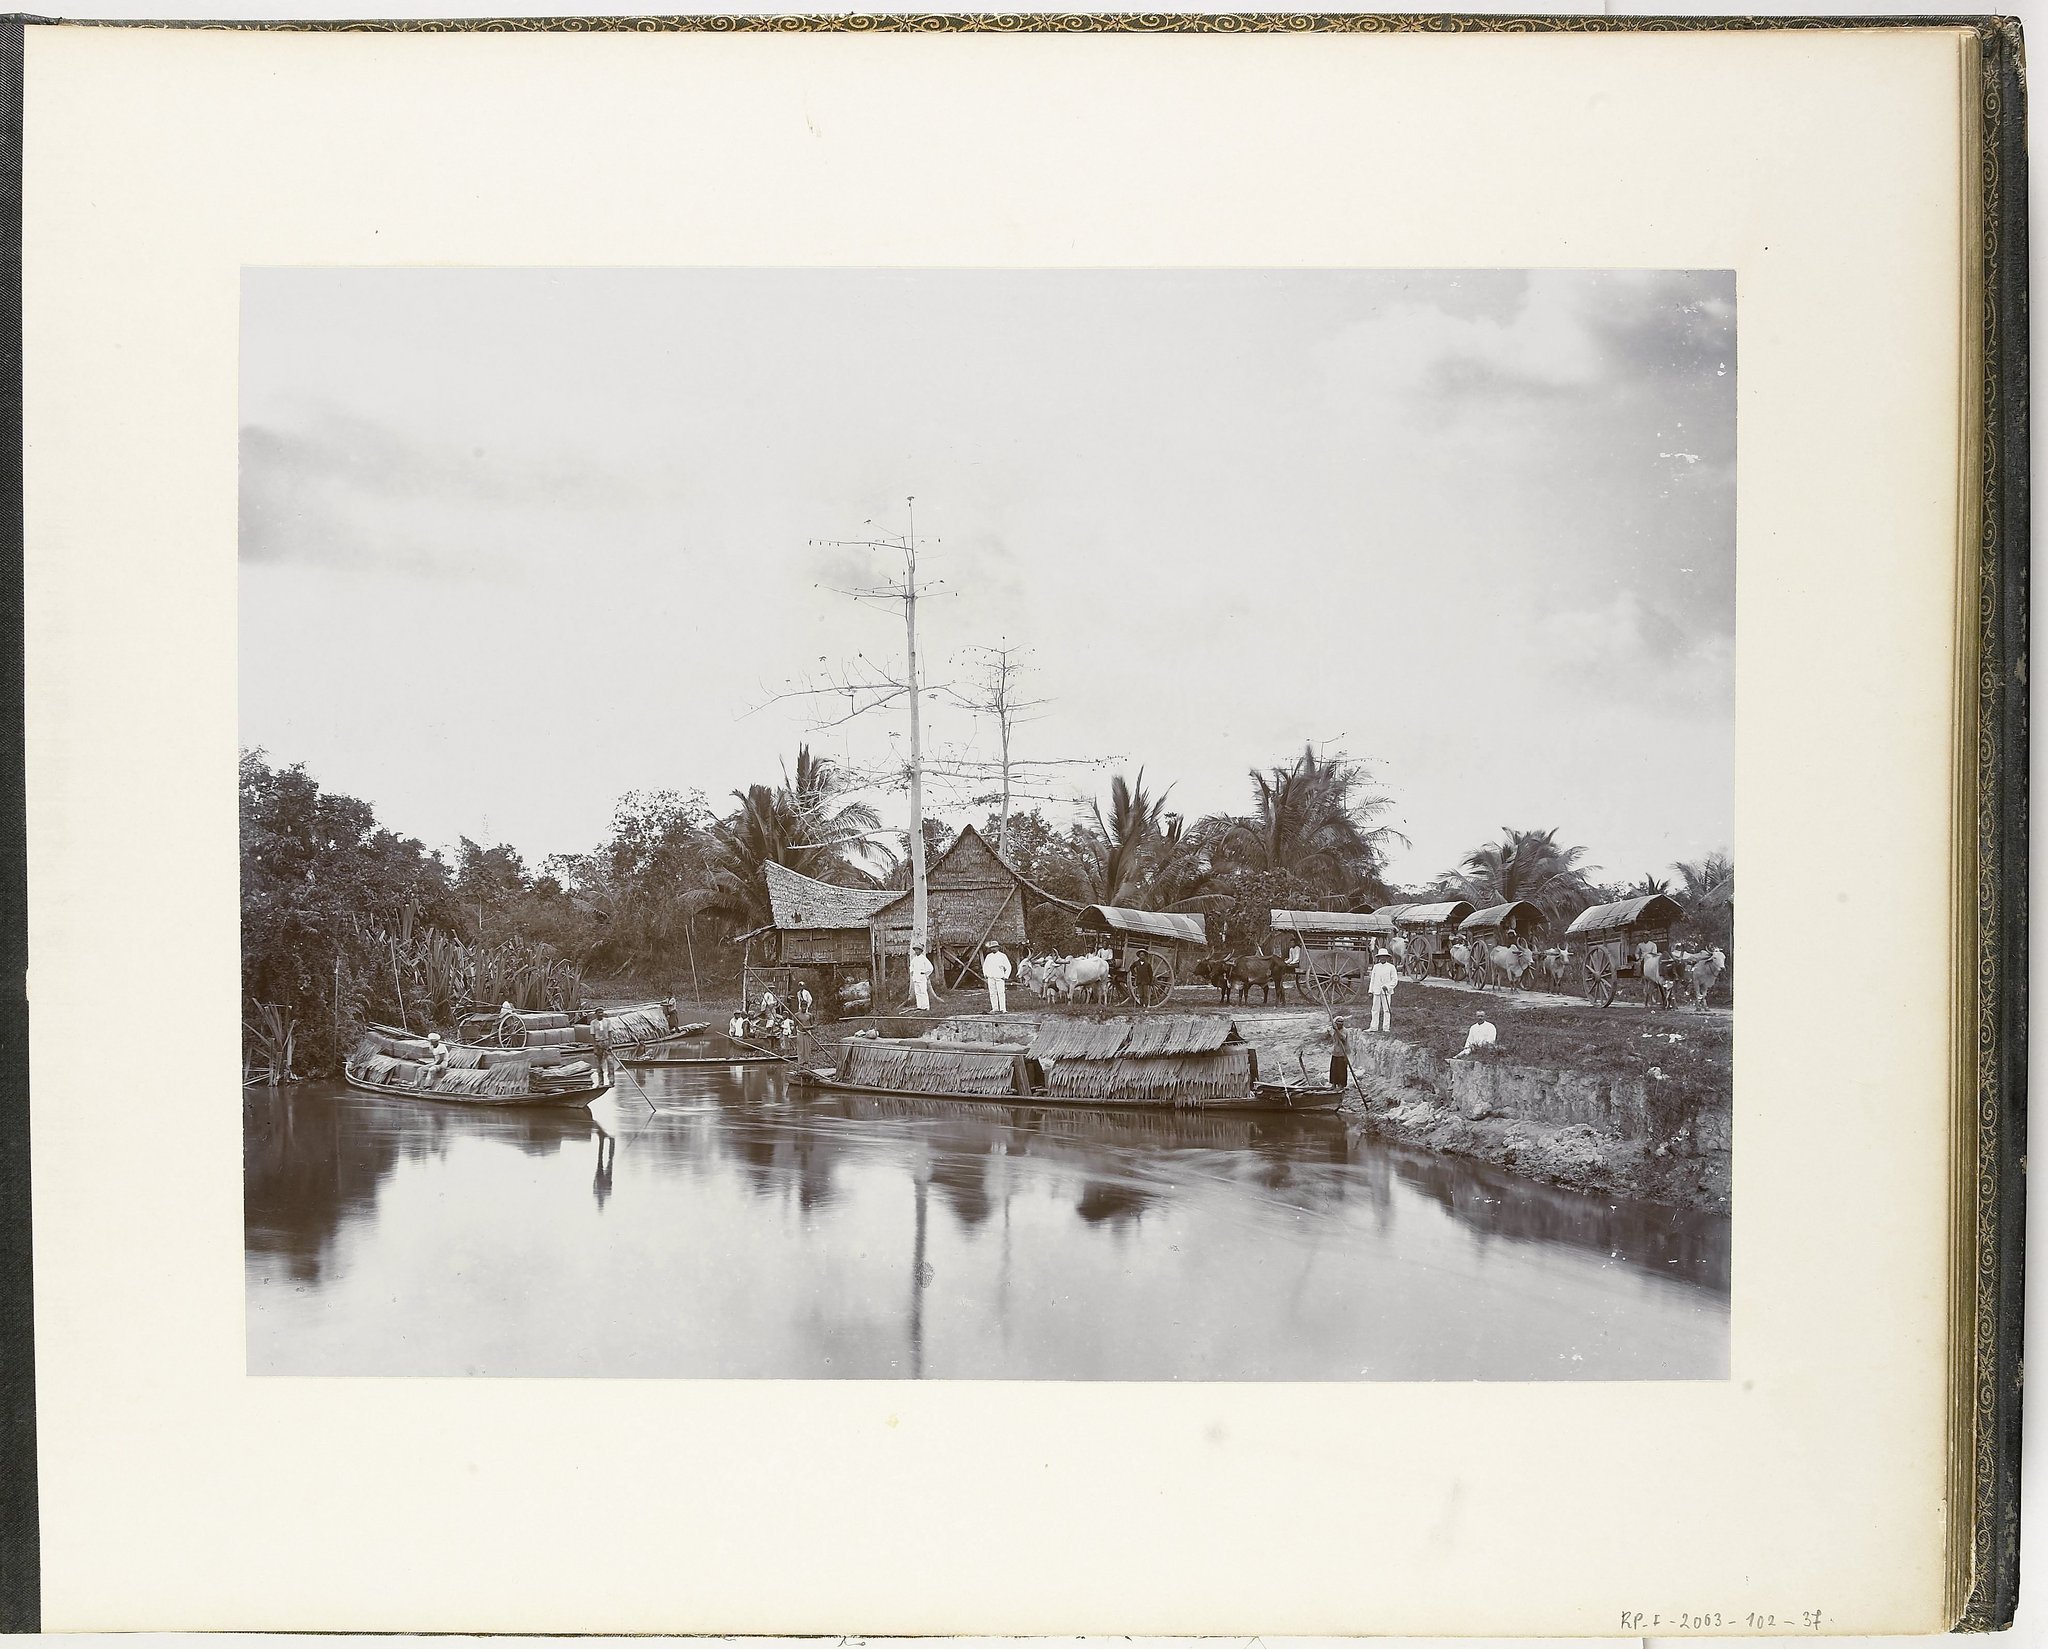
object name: photograph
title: Het verschepen van de tabak, Tandjong Kafsan, Sumatra (Verschiffen der Taback, Tandjong Kafsan)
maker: carl j. kleingrothe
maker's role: fotograaf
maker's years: 1864-1925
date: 1885-1900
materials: photographic support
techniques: collodion silver print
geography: sumatra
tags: tobacco, sumatra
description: Aanvoer van balen tabak in ossenwagens en verdere verscheping in prauwen vanaf Tandjong Kafsan op Sumatra. Onderdeel van het Sumatra fotoalbum van Paul en Lucie Sandel uit 1900.